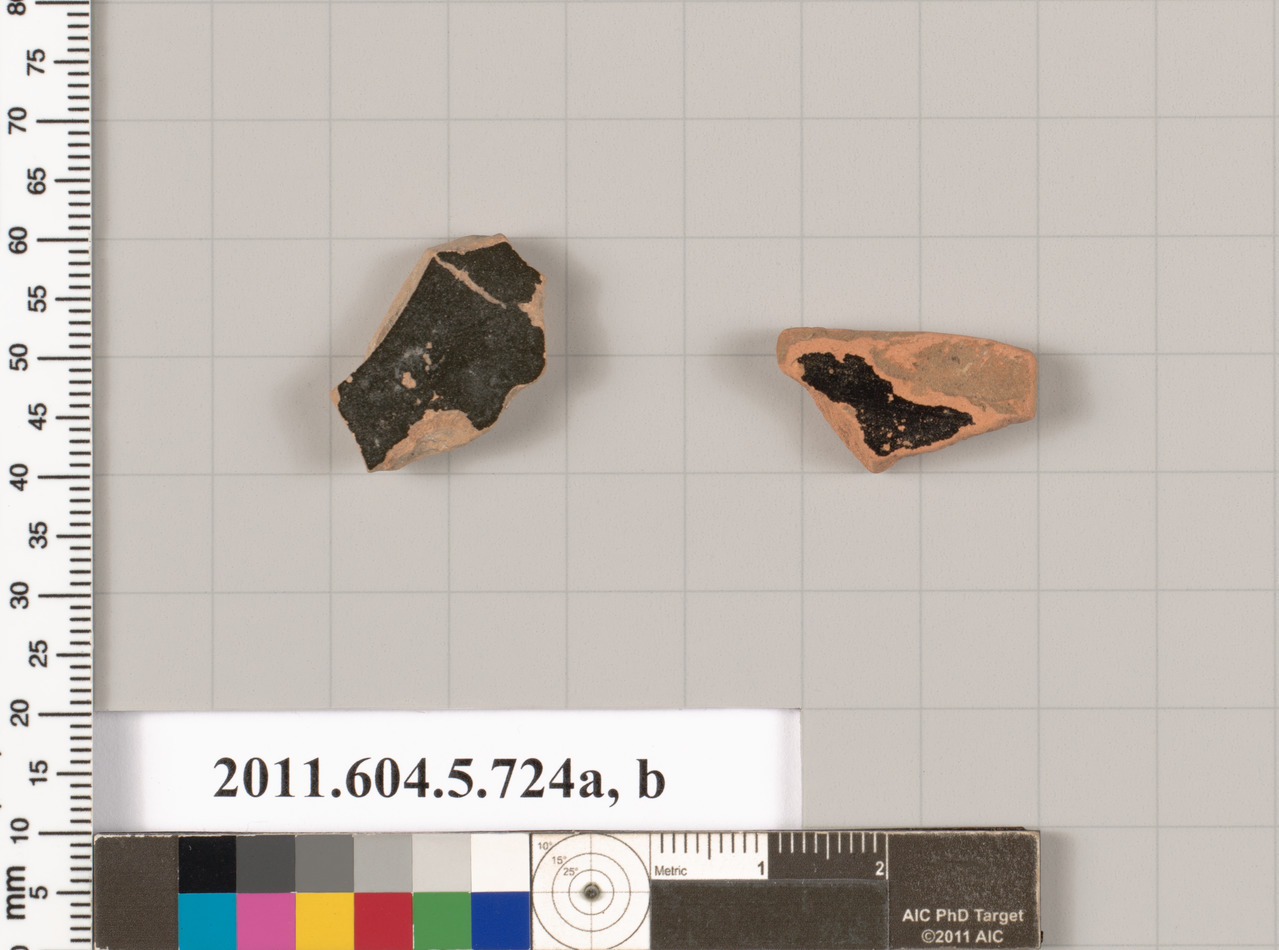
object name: kylix fragment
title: Terracotta fragments of kylikes (drinking cups)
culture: greek, attic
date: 600-401 BCE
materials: terracotta